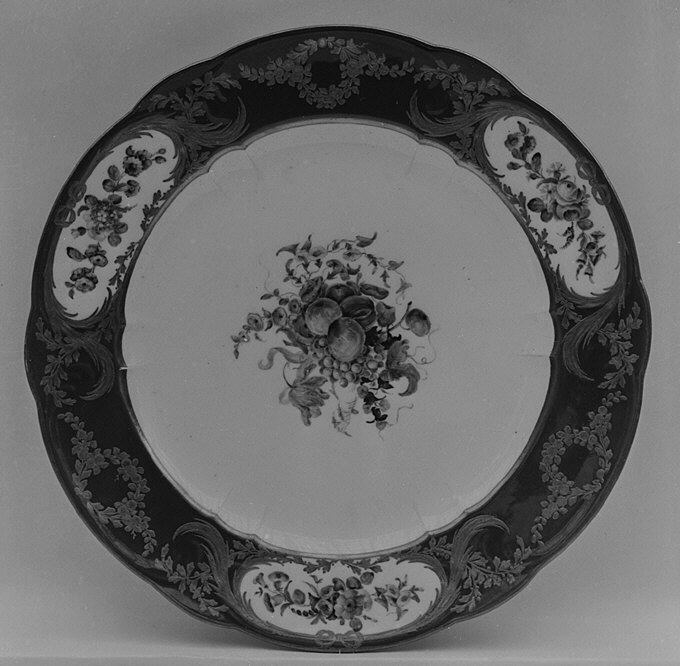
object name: plate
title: Plate (part of a service)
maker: sèvres manufactory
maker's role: manufactory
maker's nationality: french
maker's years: 1740-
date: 1784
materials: soft paste porcelain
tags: fruit,flowers